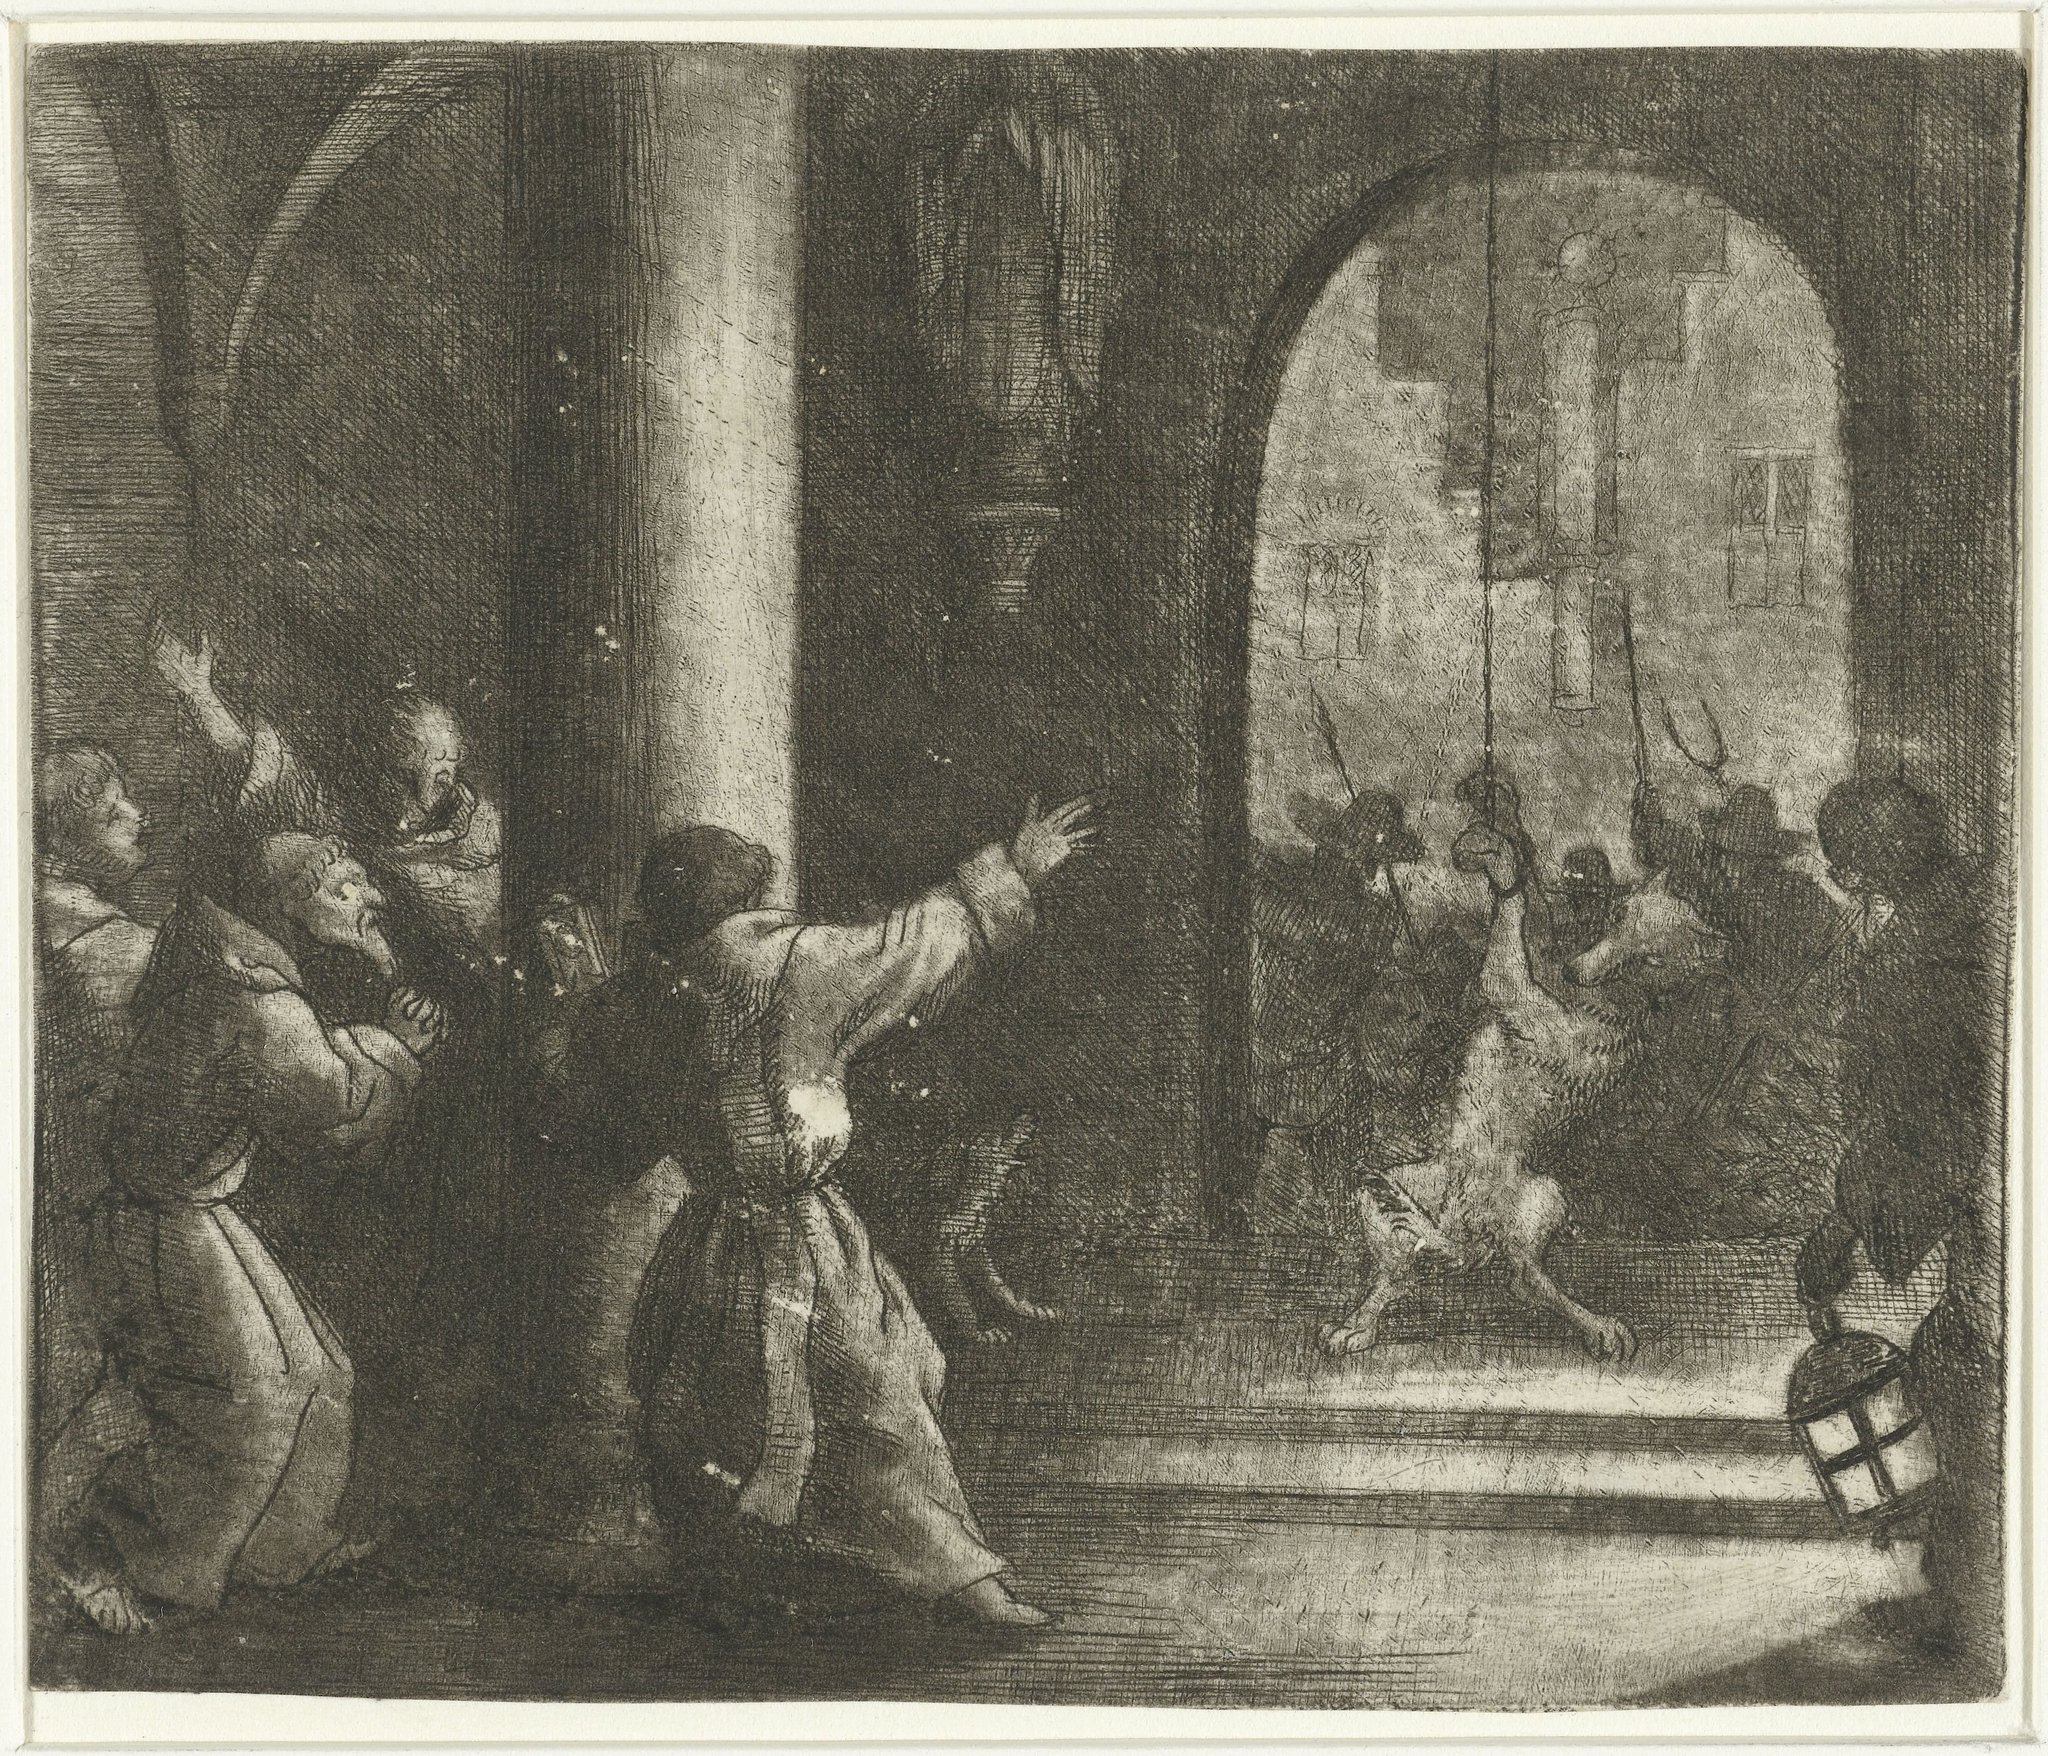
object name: print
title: Reinaert de vos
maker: allaert van everdingen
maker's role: draughtsman, painter, print maker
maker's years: 1621-1675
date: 1665-1675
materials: paper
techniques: etching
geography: netherlands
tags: fable of reynard the fox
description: Isengrijn de wolf, met beide voorpoten vast in een touw, wordt omringd door een boze menigte. Naast hem, in de schaduw, staat Reinaert de vos.